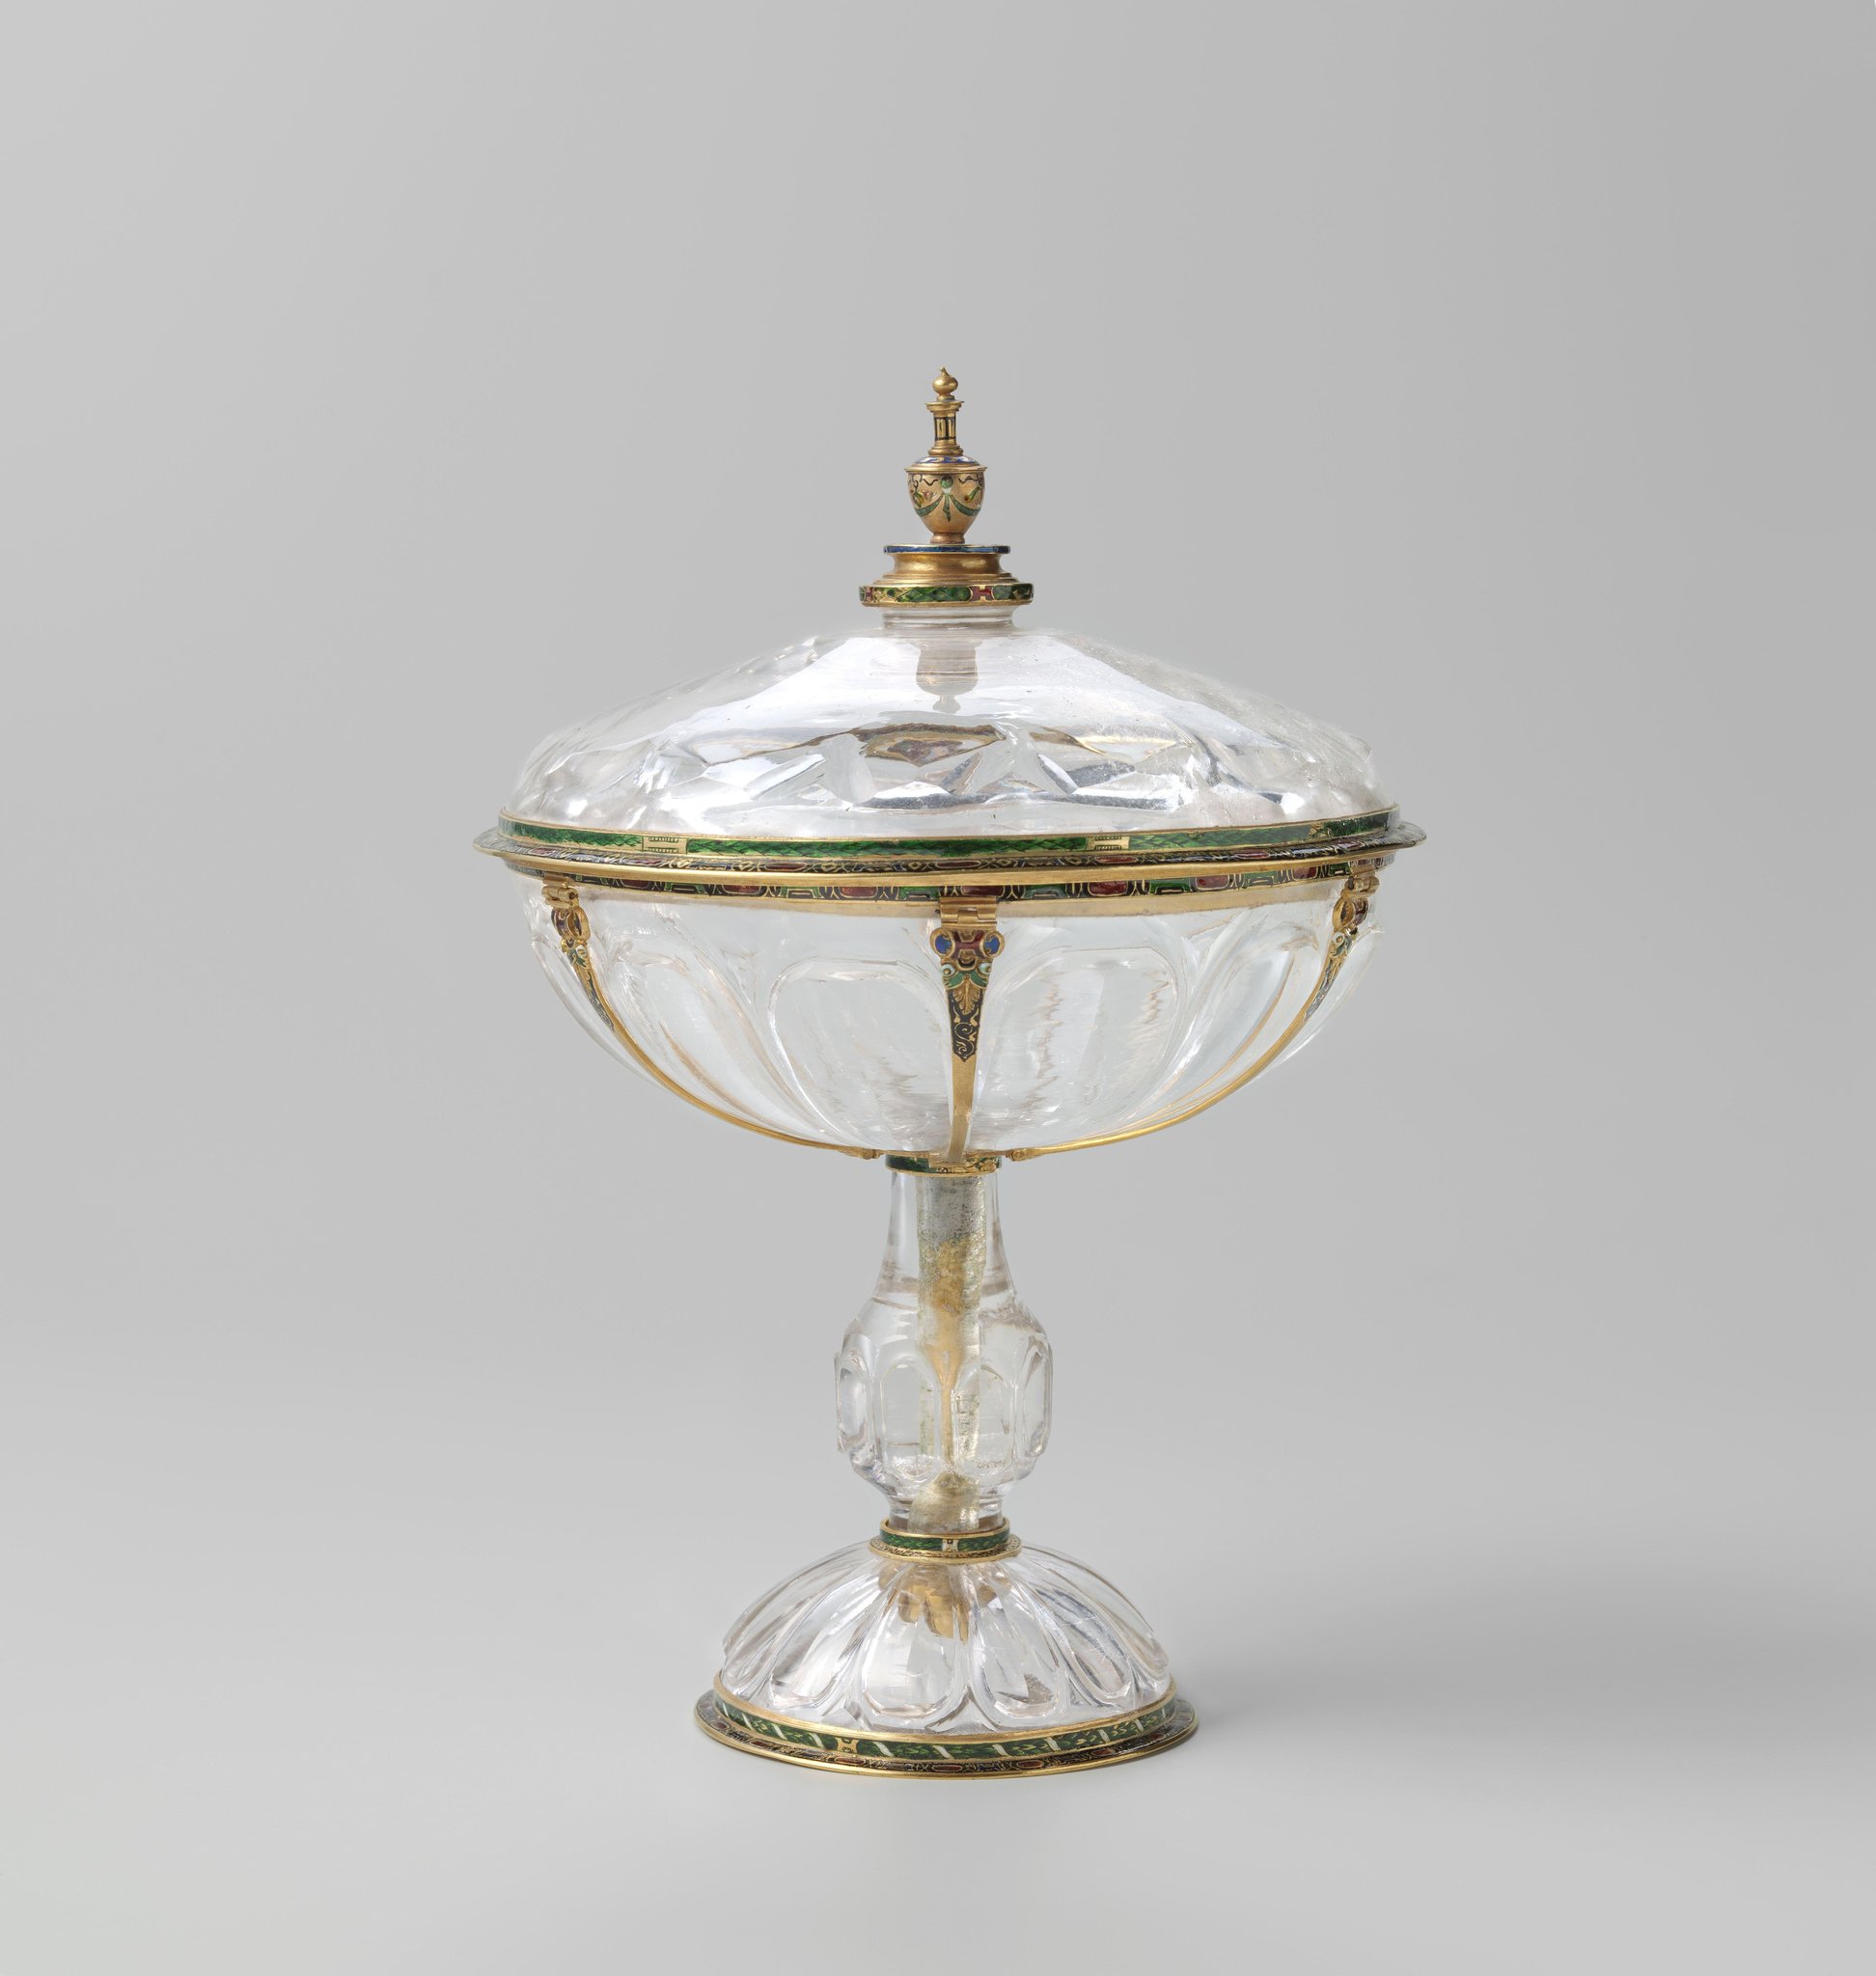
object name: coupe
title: Lidded dish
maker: Anonymous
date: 1600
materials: gold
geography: freiburg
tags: ornaments ~ art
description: Deksel van bergkristal in een gouden montuur.